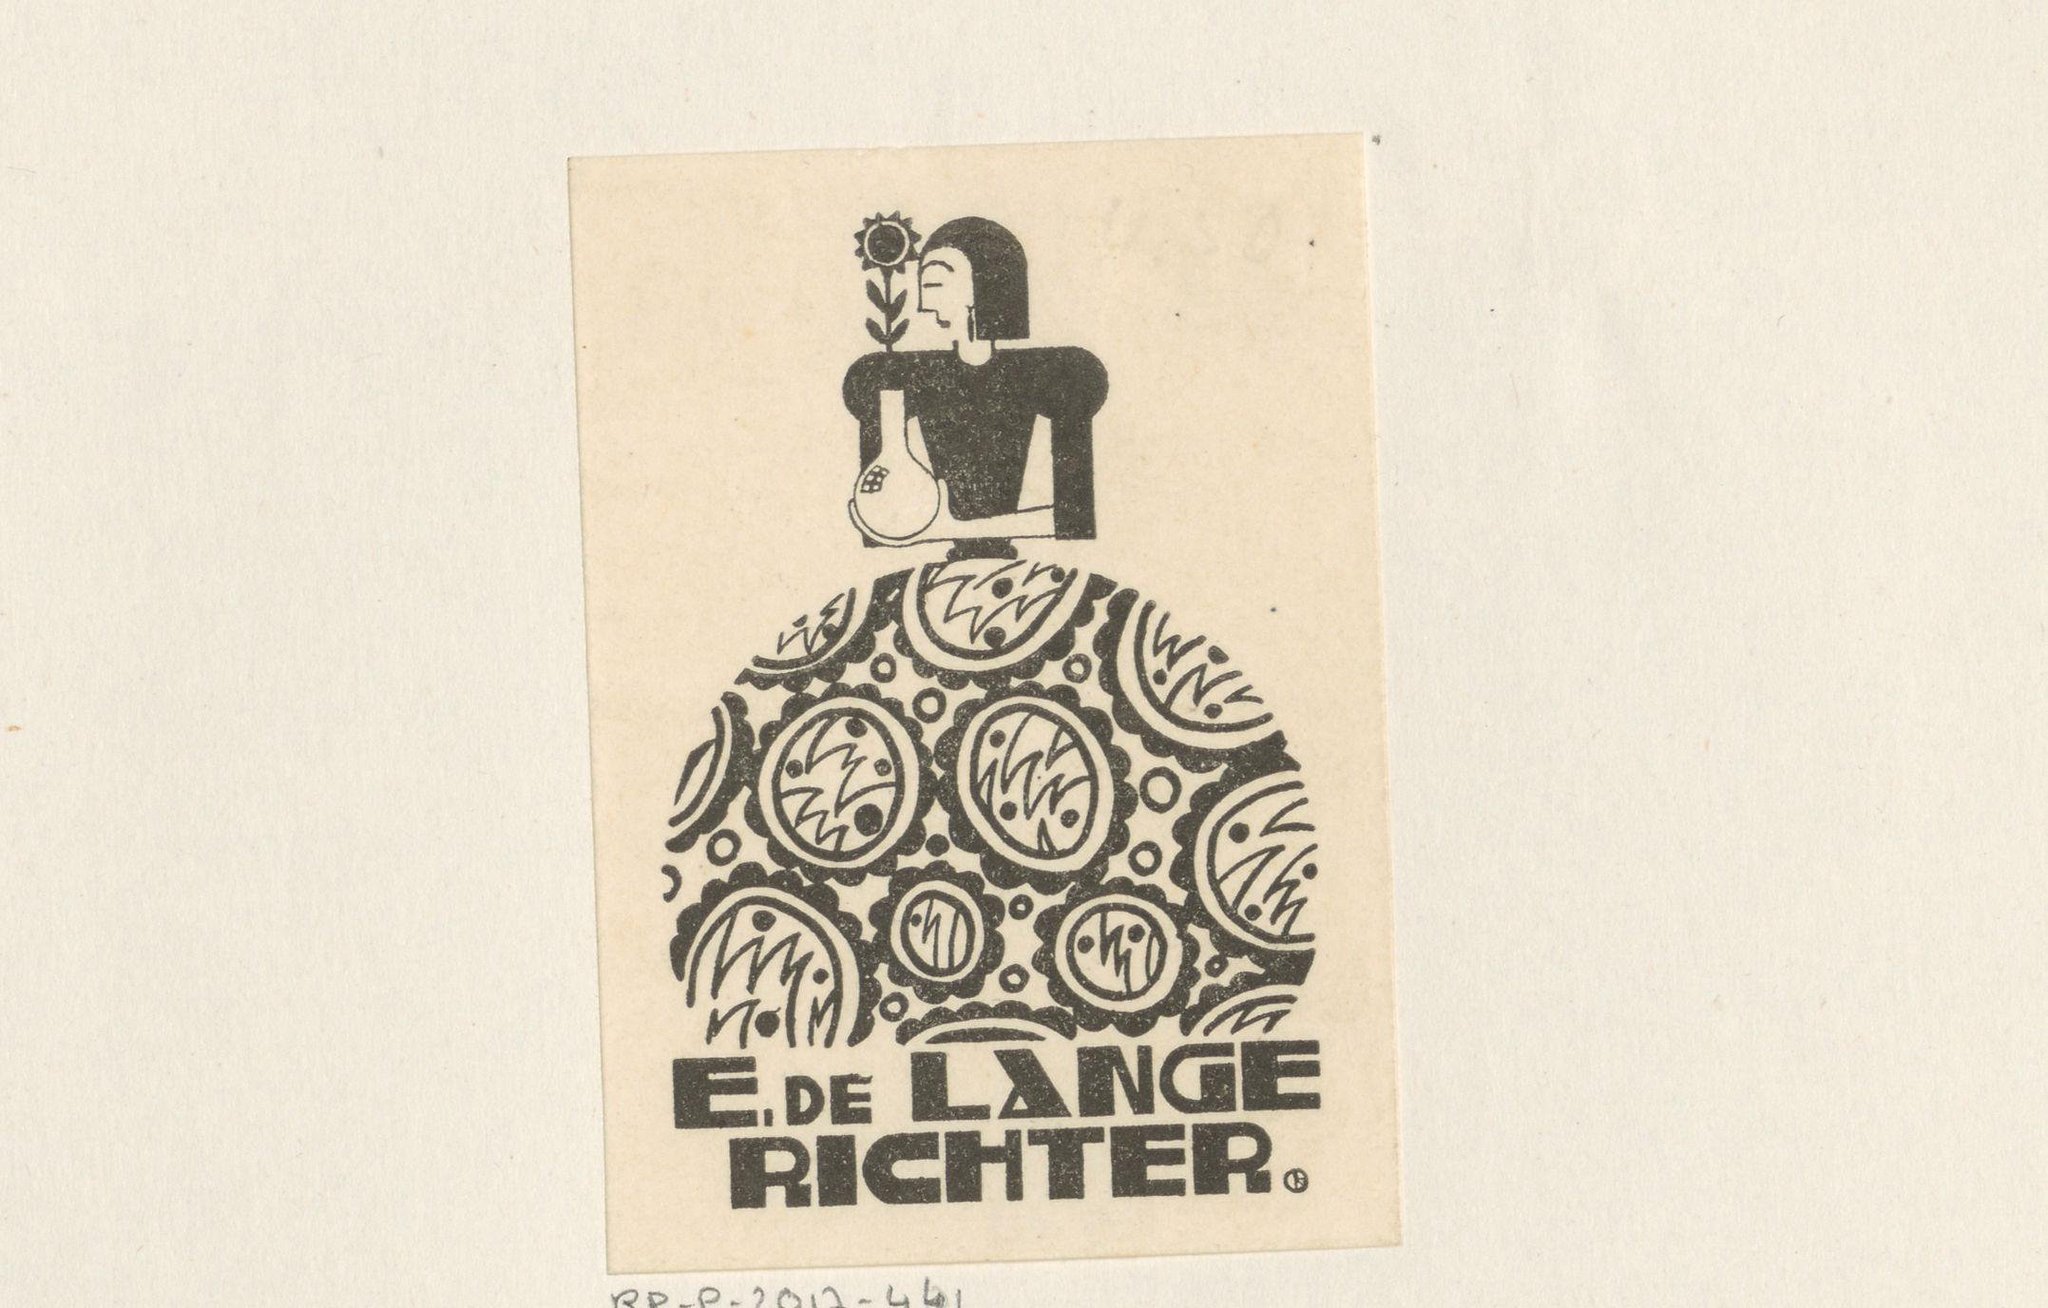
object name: bookplate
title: Ex libris van E. de Lange Richter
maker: Anonymous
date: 1900-1999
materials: paper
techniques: printing block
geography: netherlands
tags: adult woman, flowers in a vase